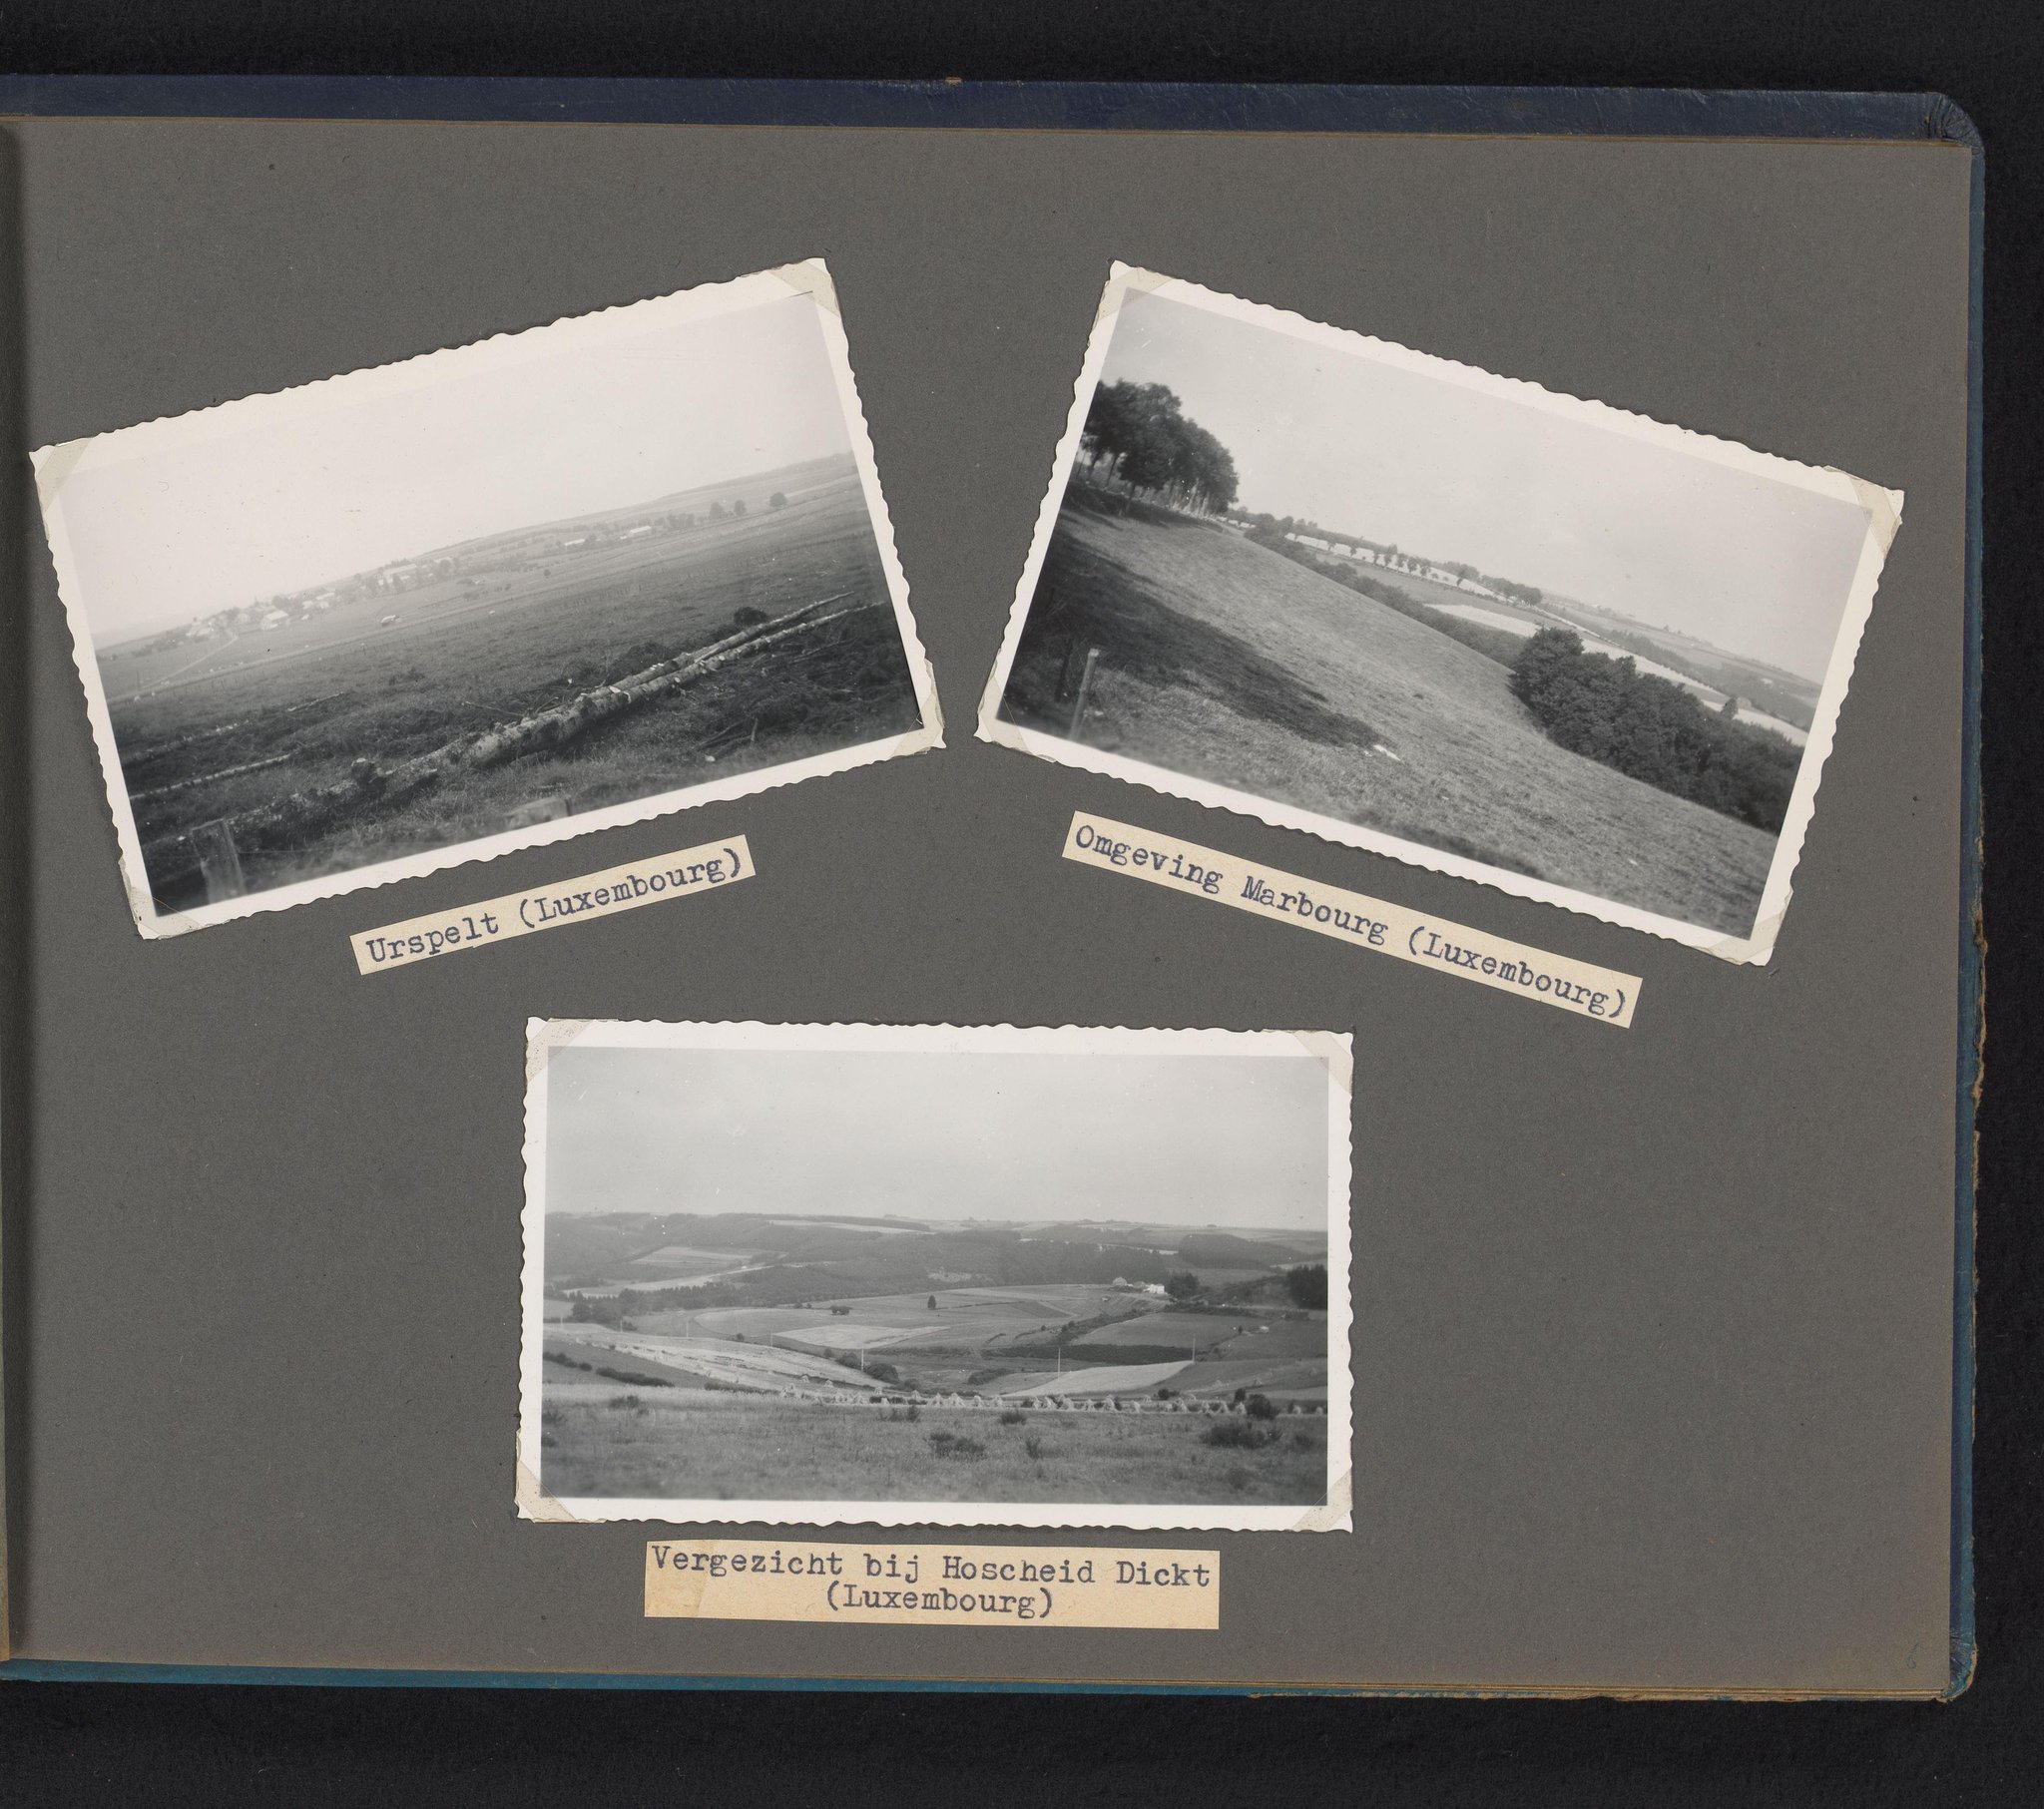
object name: photograph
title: Landschappen in Luxemburg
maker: Anonymous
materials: paper, photographic support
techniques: gelatin silver print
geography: luxembourg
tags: the family travelling, on holiday, riding, cycling (recreation), outing, pleasure trip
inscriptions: inscription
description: Albumblad met drie foto's genomen tijdens een fietsvakantie. Landschappen in Luxemburg. Onder de foto's uitgeknipte papiertjes met getypte opschriften. Onderdeel van het derde fotoalbum met foto's van familievakanties in Nederland, België en Luxemburg in 1952-1953.